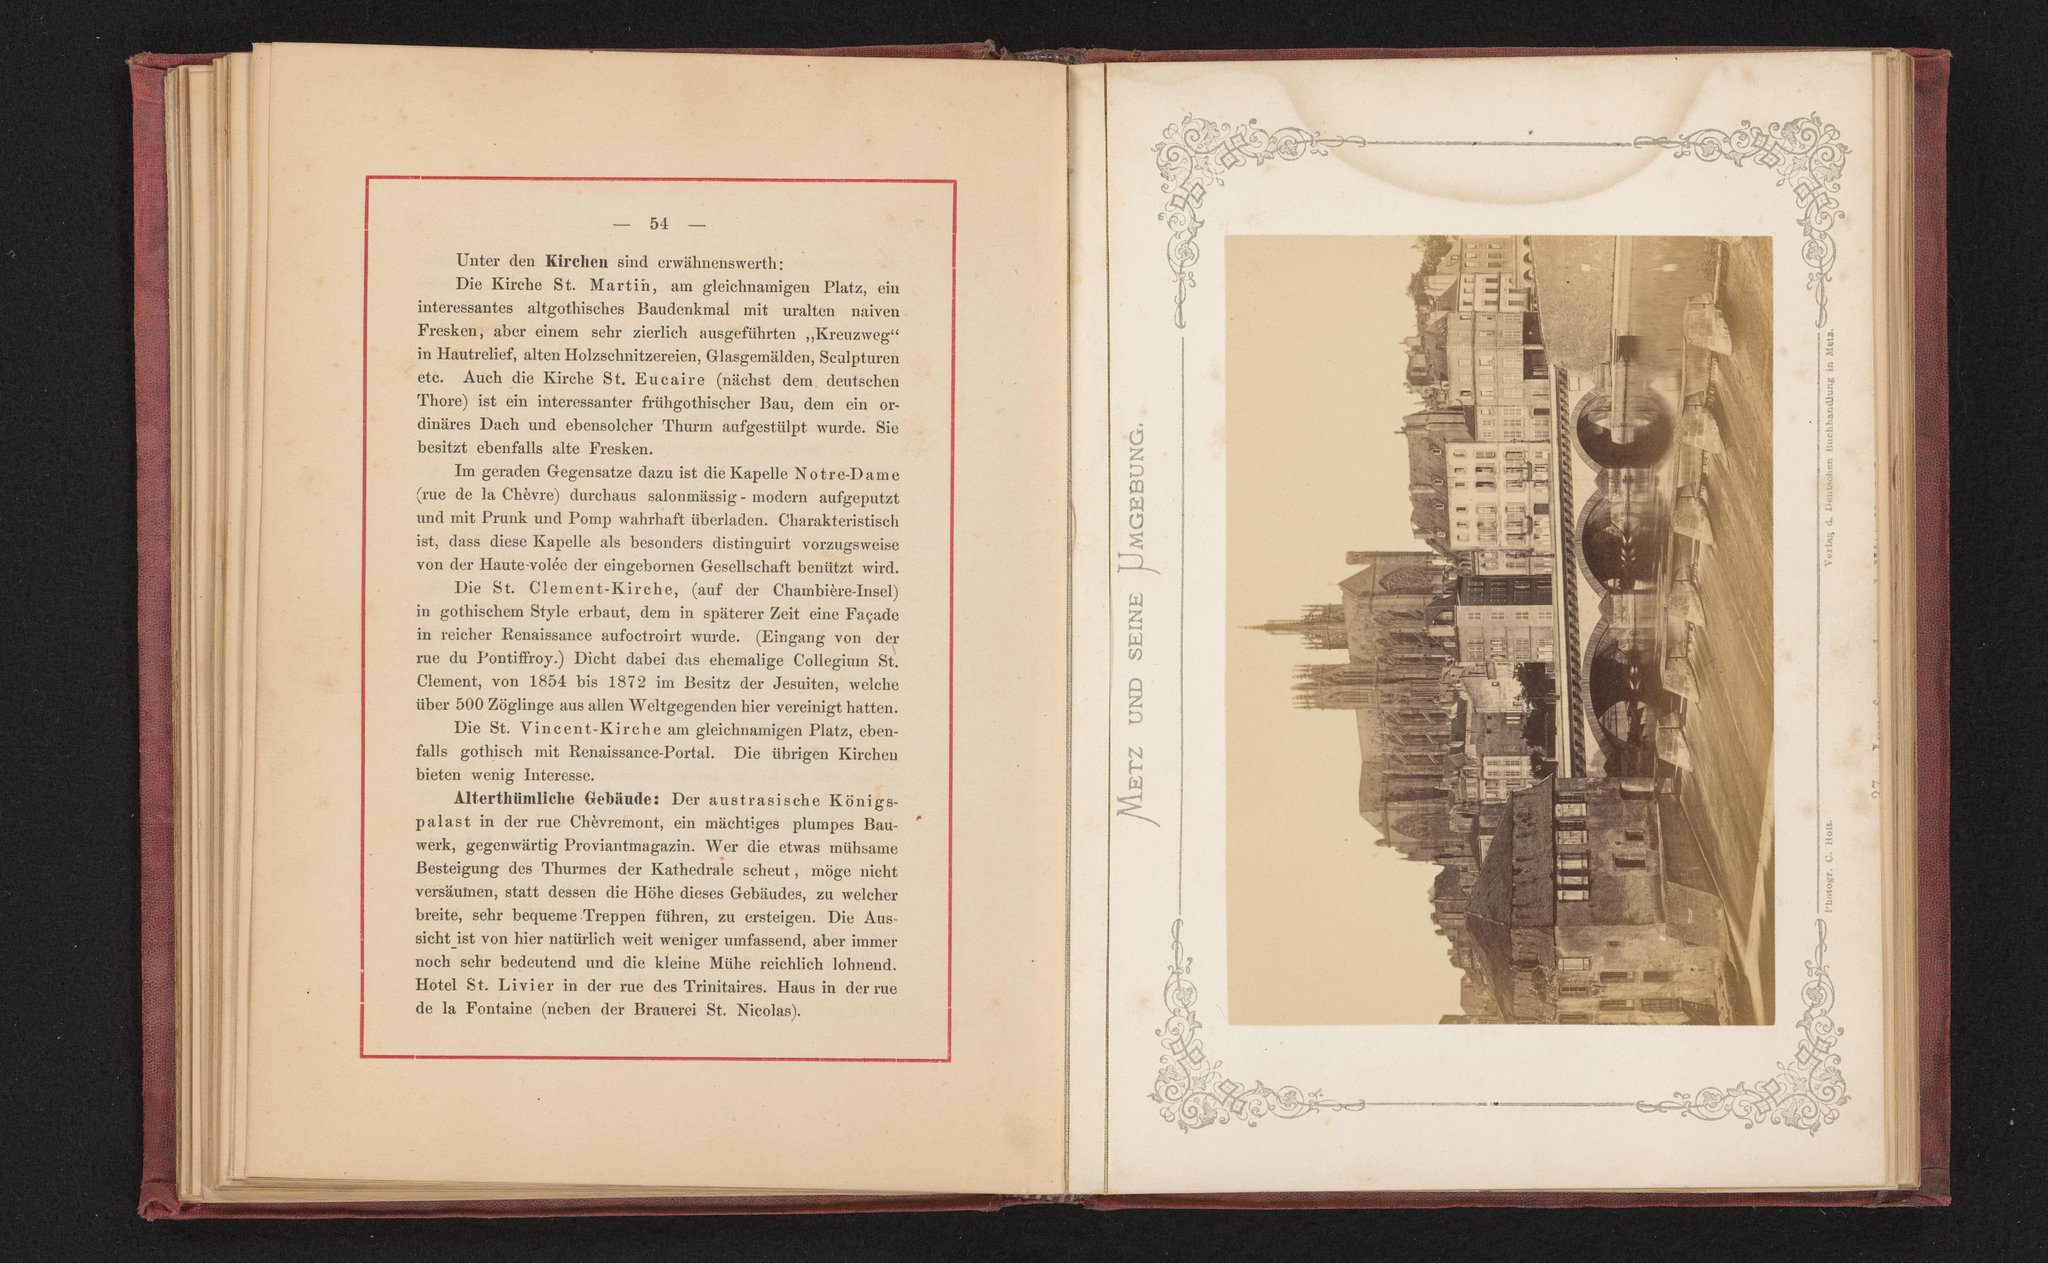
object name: page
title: Gezicht op de kathedraal van Metz en een brug over de Moezel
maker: c. holt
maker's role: fotograaf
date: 1865-1875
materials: photographic support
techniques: albumen print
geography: metz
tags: city-view, and landscape with man-made constructions, church (exterior), bridge in city across river, canal, etc.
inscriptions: number: ‘[...]7’